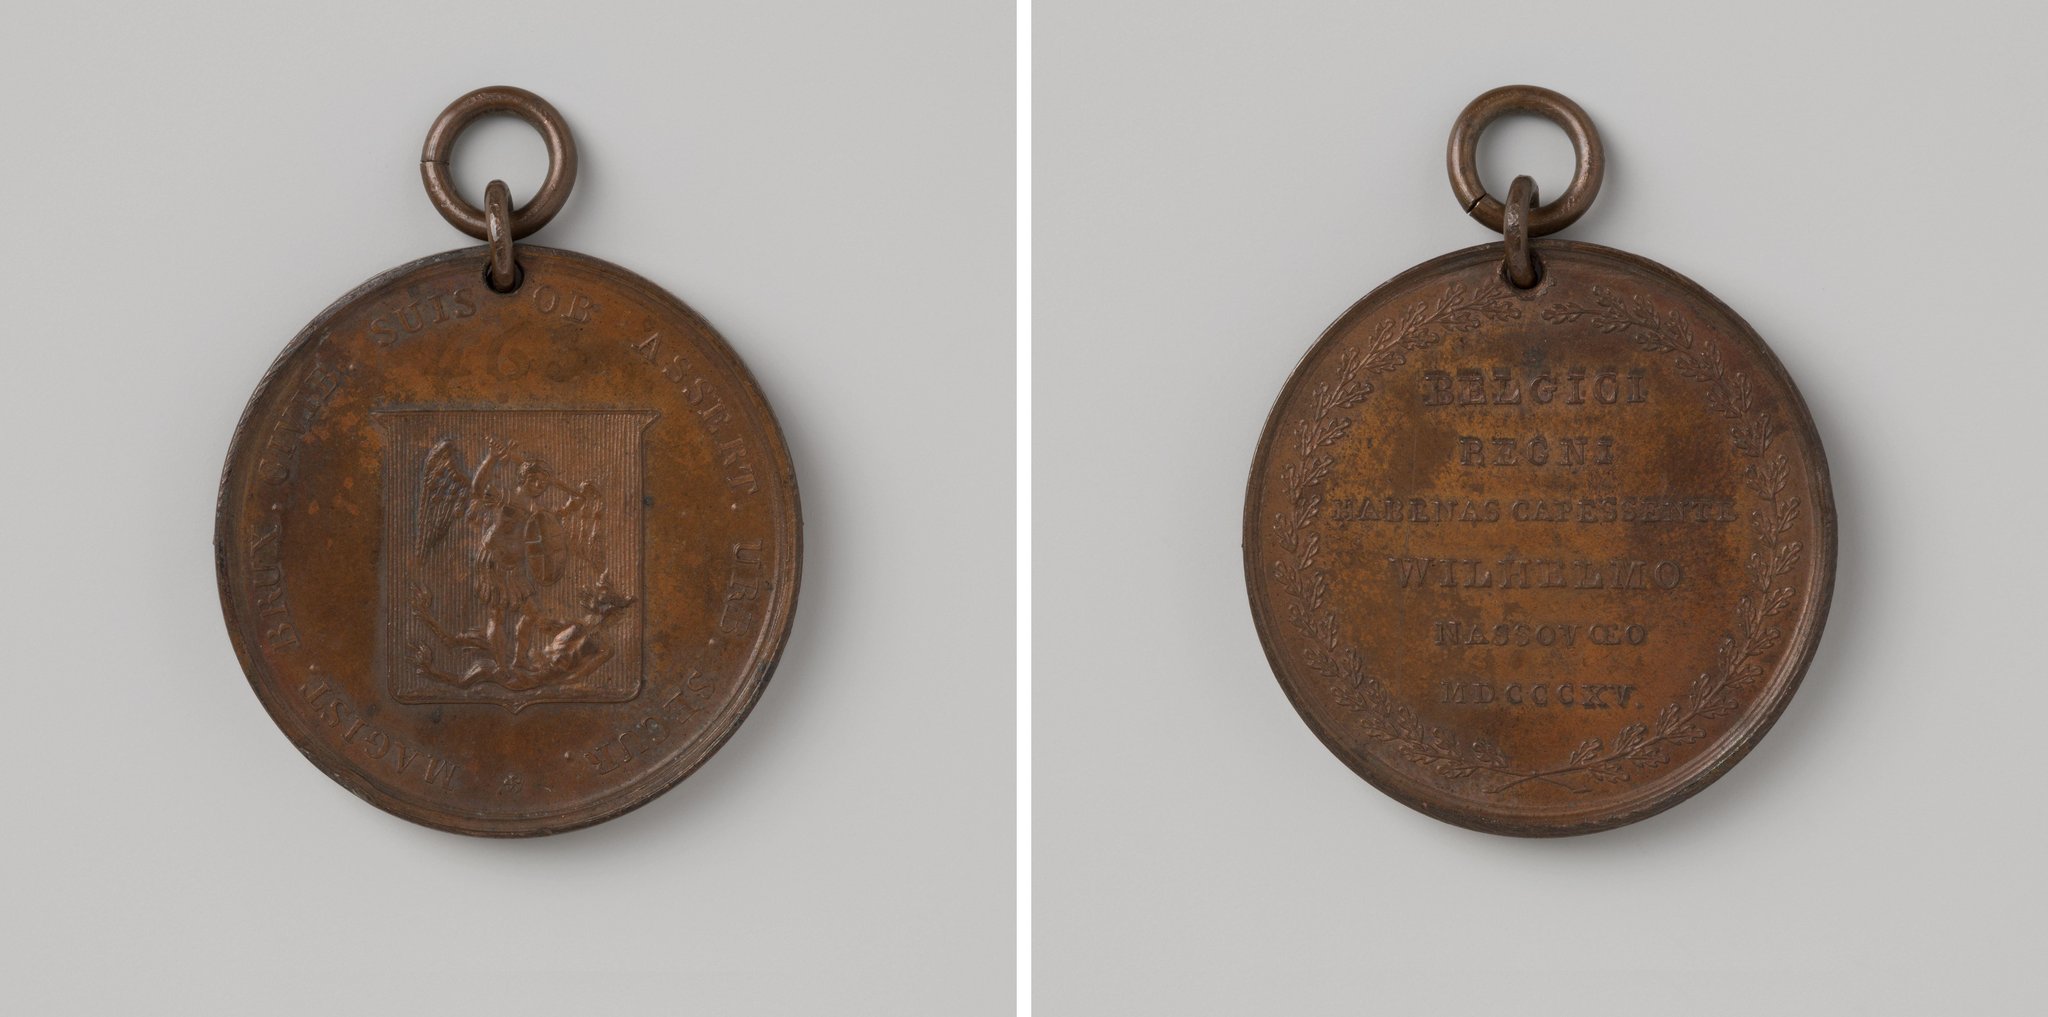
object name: honorary medal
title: Verdediging van Brussel, penning door de stad uitgereikt aan de gewapende burgerij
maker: Anonymous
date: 1815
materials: bronze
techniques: striking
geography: brussels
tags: the hague, berlin, william i of the netherlands, brussels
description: Bronzen penning aan twee draagringen. Voorzijde: wapenschild binnen omschrift. Keerzijde: opschrift binnen eikekrans